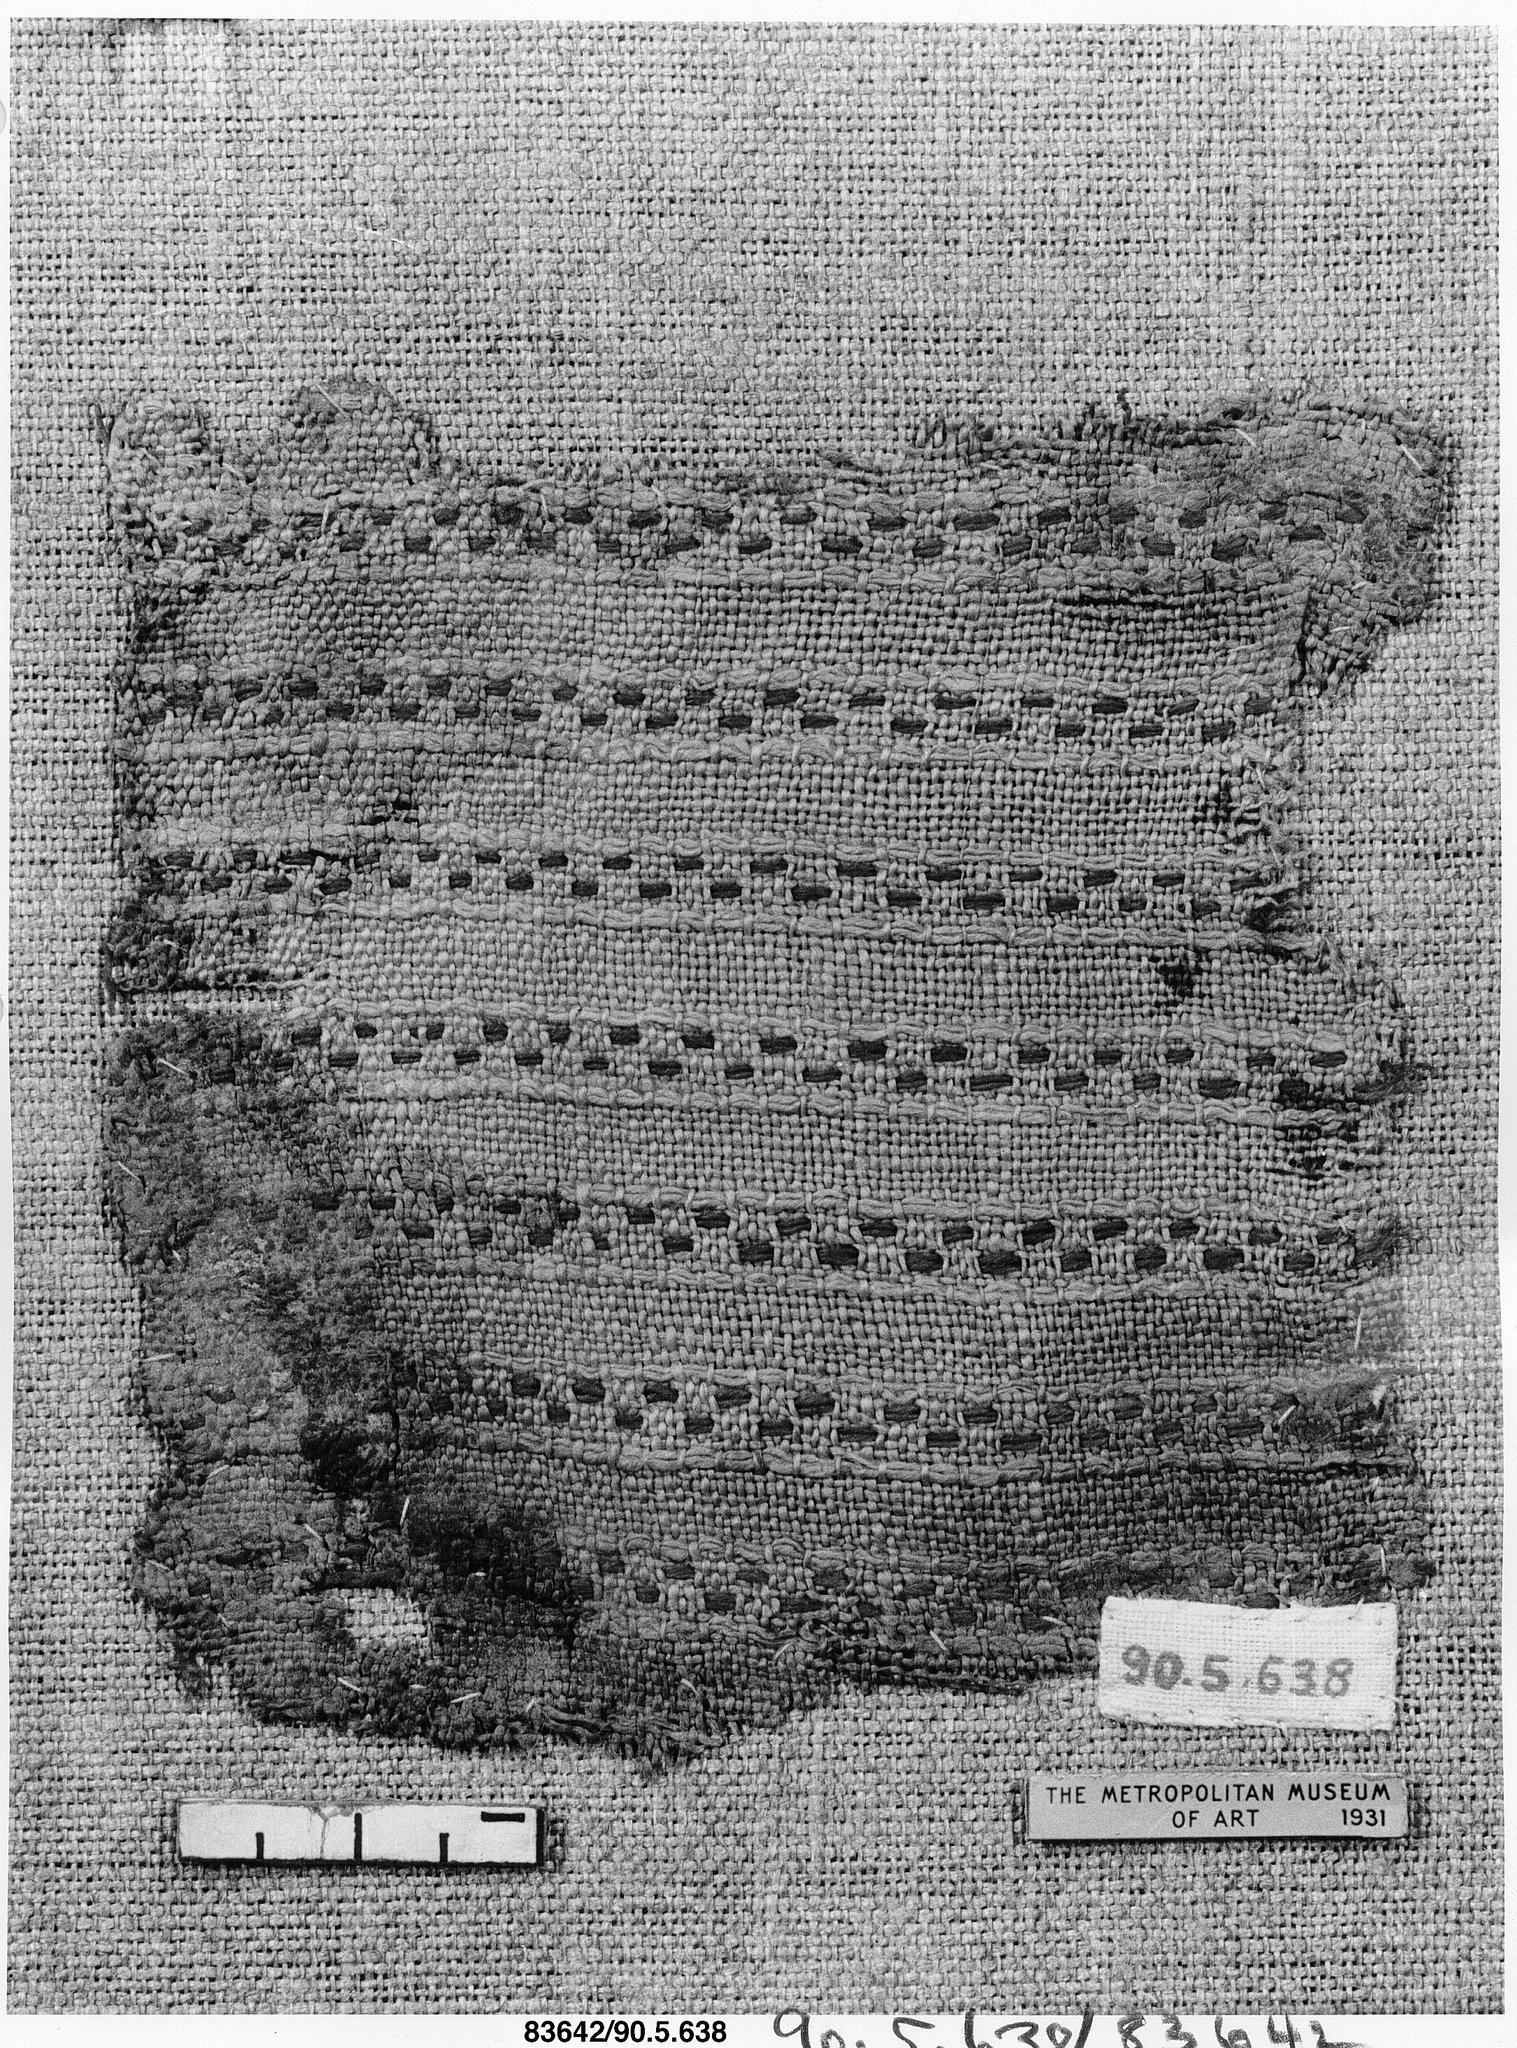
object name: textile fragment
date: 301-500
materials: linen, wool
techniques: weave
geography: egypt